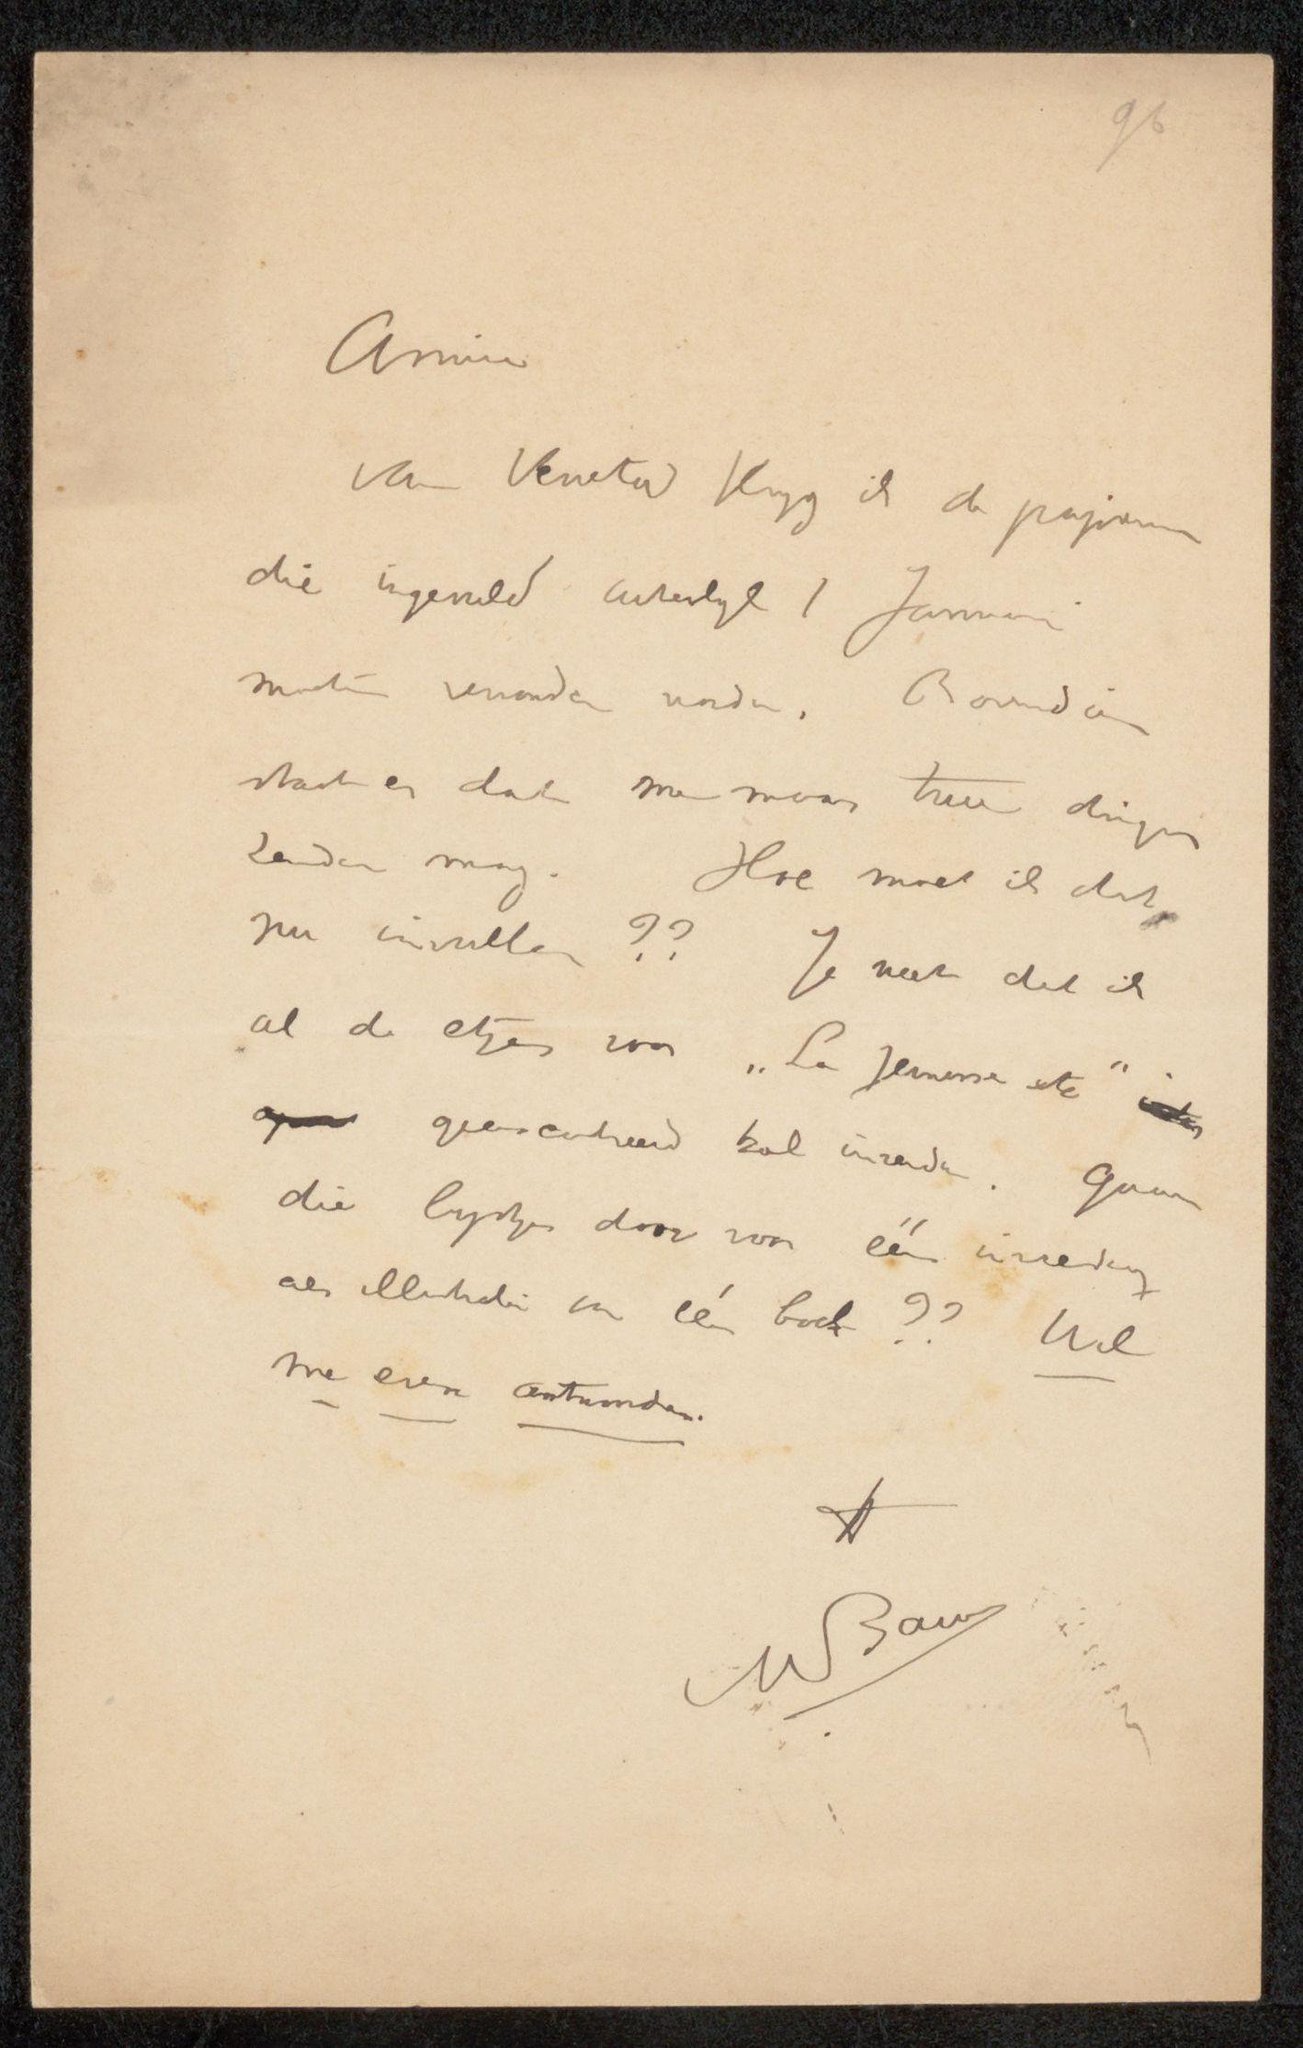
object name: letter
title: Brief aan Philip Zilcken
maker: marius bauer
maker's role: draughtsman, print maker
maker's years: 1867-1932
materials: ink, paper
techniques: pen, writing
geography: bussum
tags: the hague, painter, draughtsman, philip zilcken, venice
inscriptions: collector's mark: ‘RPK’